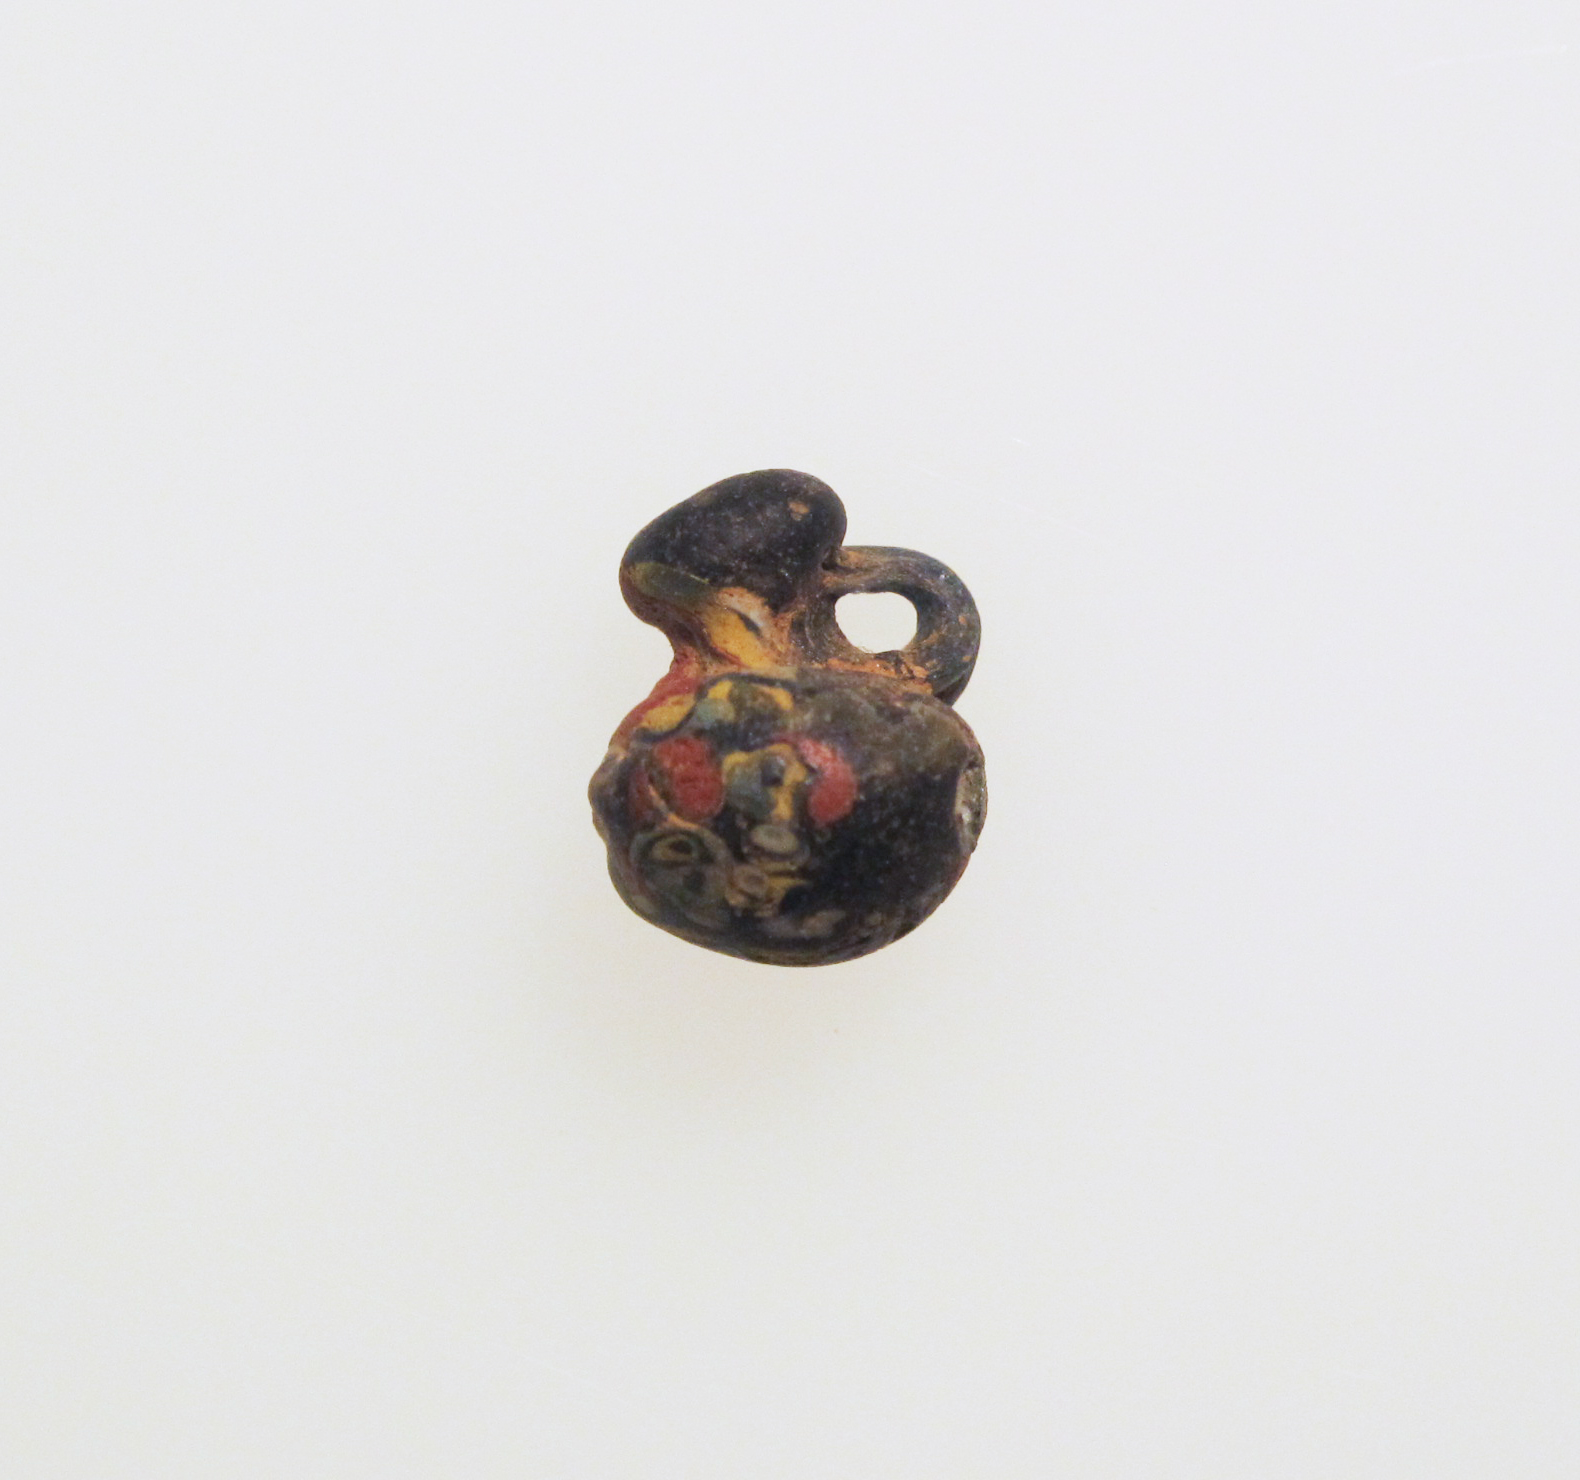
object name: pendant in the form of a vase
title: Glass pendant shaped like a jug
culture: roman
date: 201-400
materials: glass